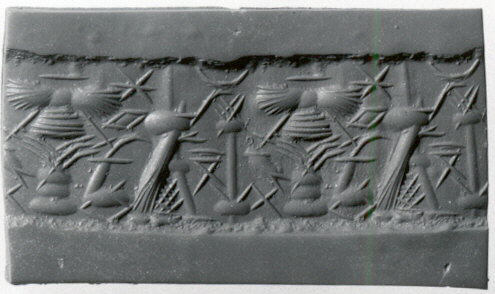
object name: cylinder seal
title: Cylinder seal with cultic scene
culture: assyro-babylonian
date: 700-601 BCE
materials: stone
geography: mesopotamia